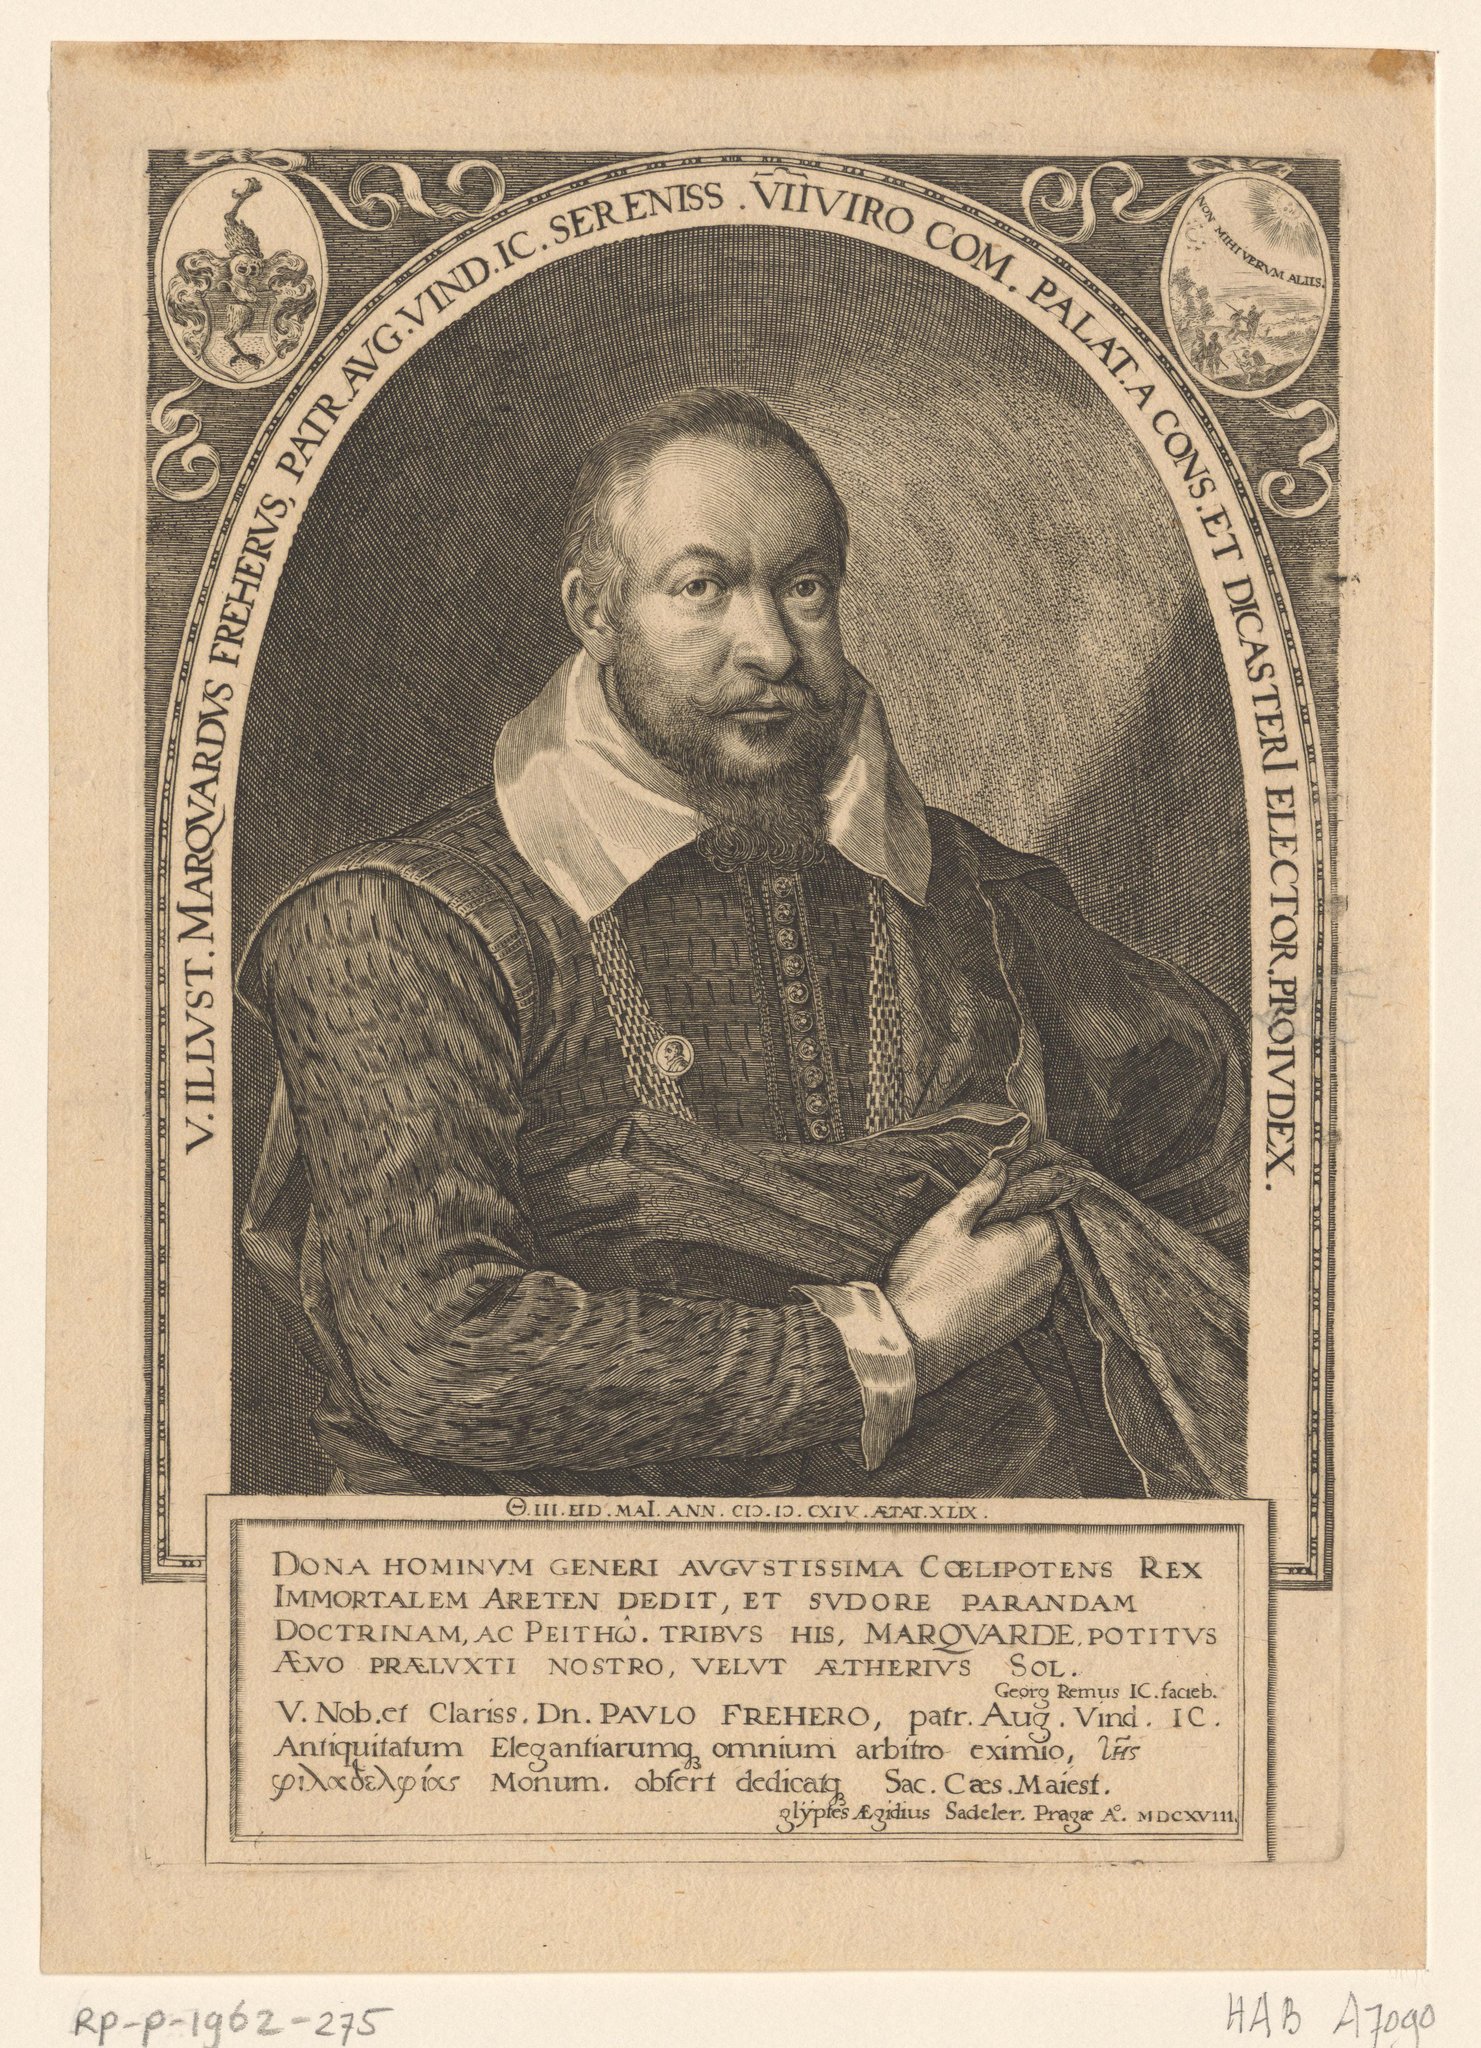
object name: print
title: Portret van Marquard Freher op 49-jarige leeftijd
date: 1618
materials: paper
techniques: engraving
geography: prague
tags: augsburg, historical persons, armorial bearing, heraldry (...) - device, motto, armorial bearing, heraldry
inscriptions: collector's mark: Lugt 2228, number: ‘N 284’